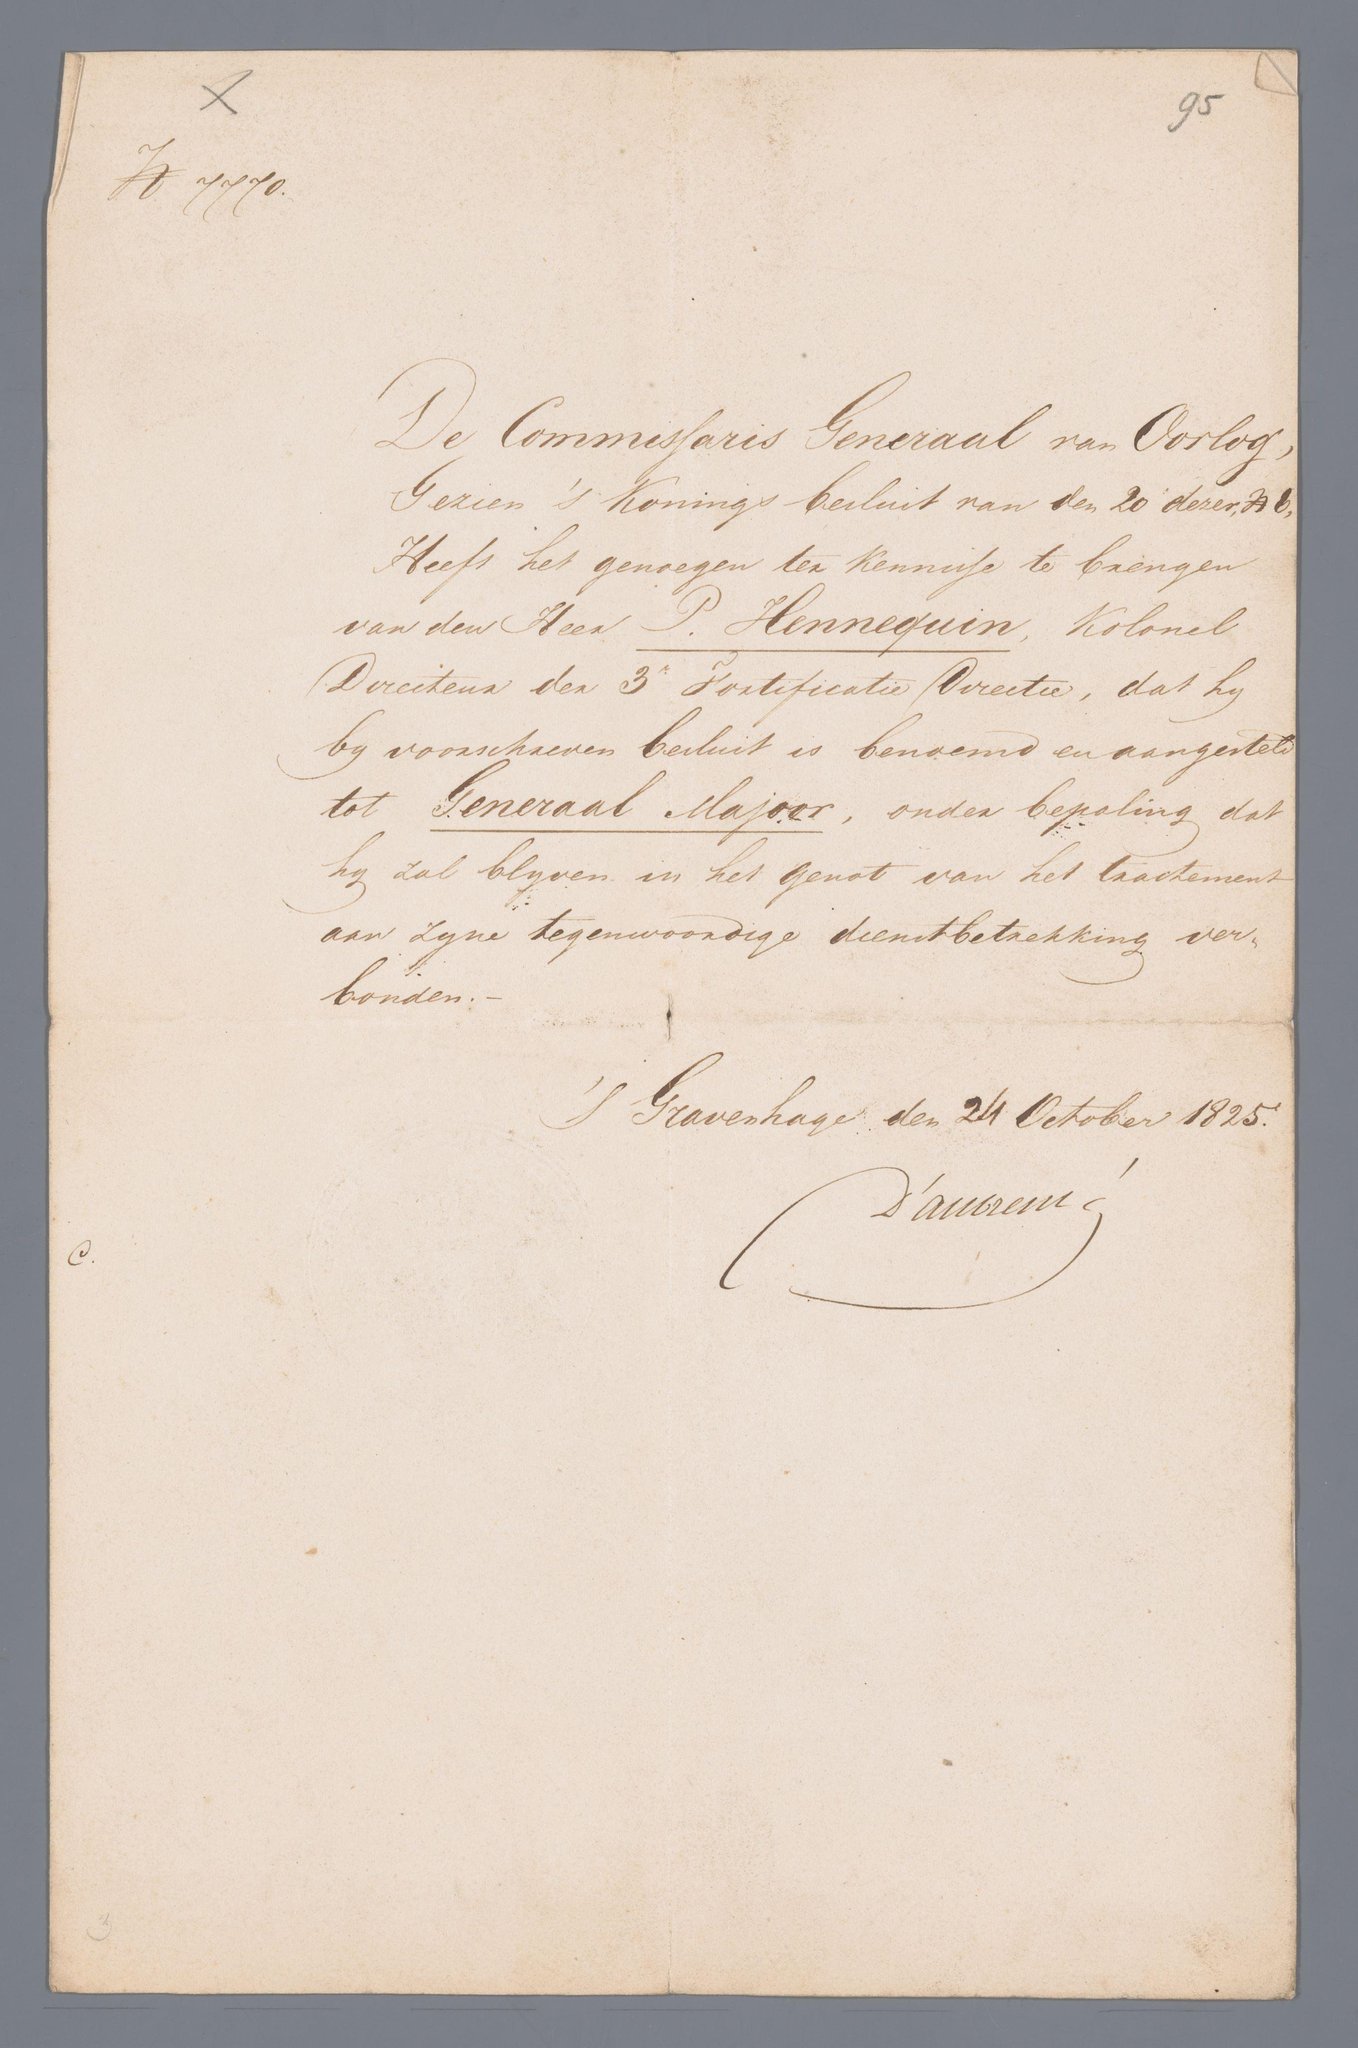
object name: document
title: Acte van benoeming Pieter Hennequin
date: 1825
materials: ink, paper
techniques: writing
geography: the hague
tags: pieter hennequin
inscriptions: date